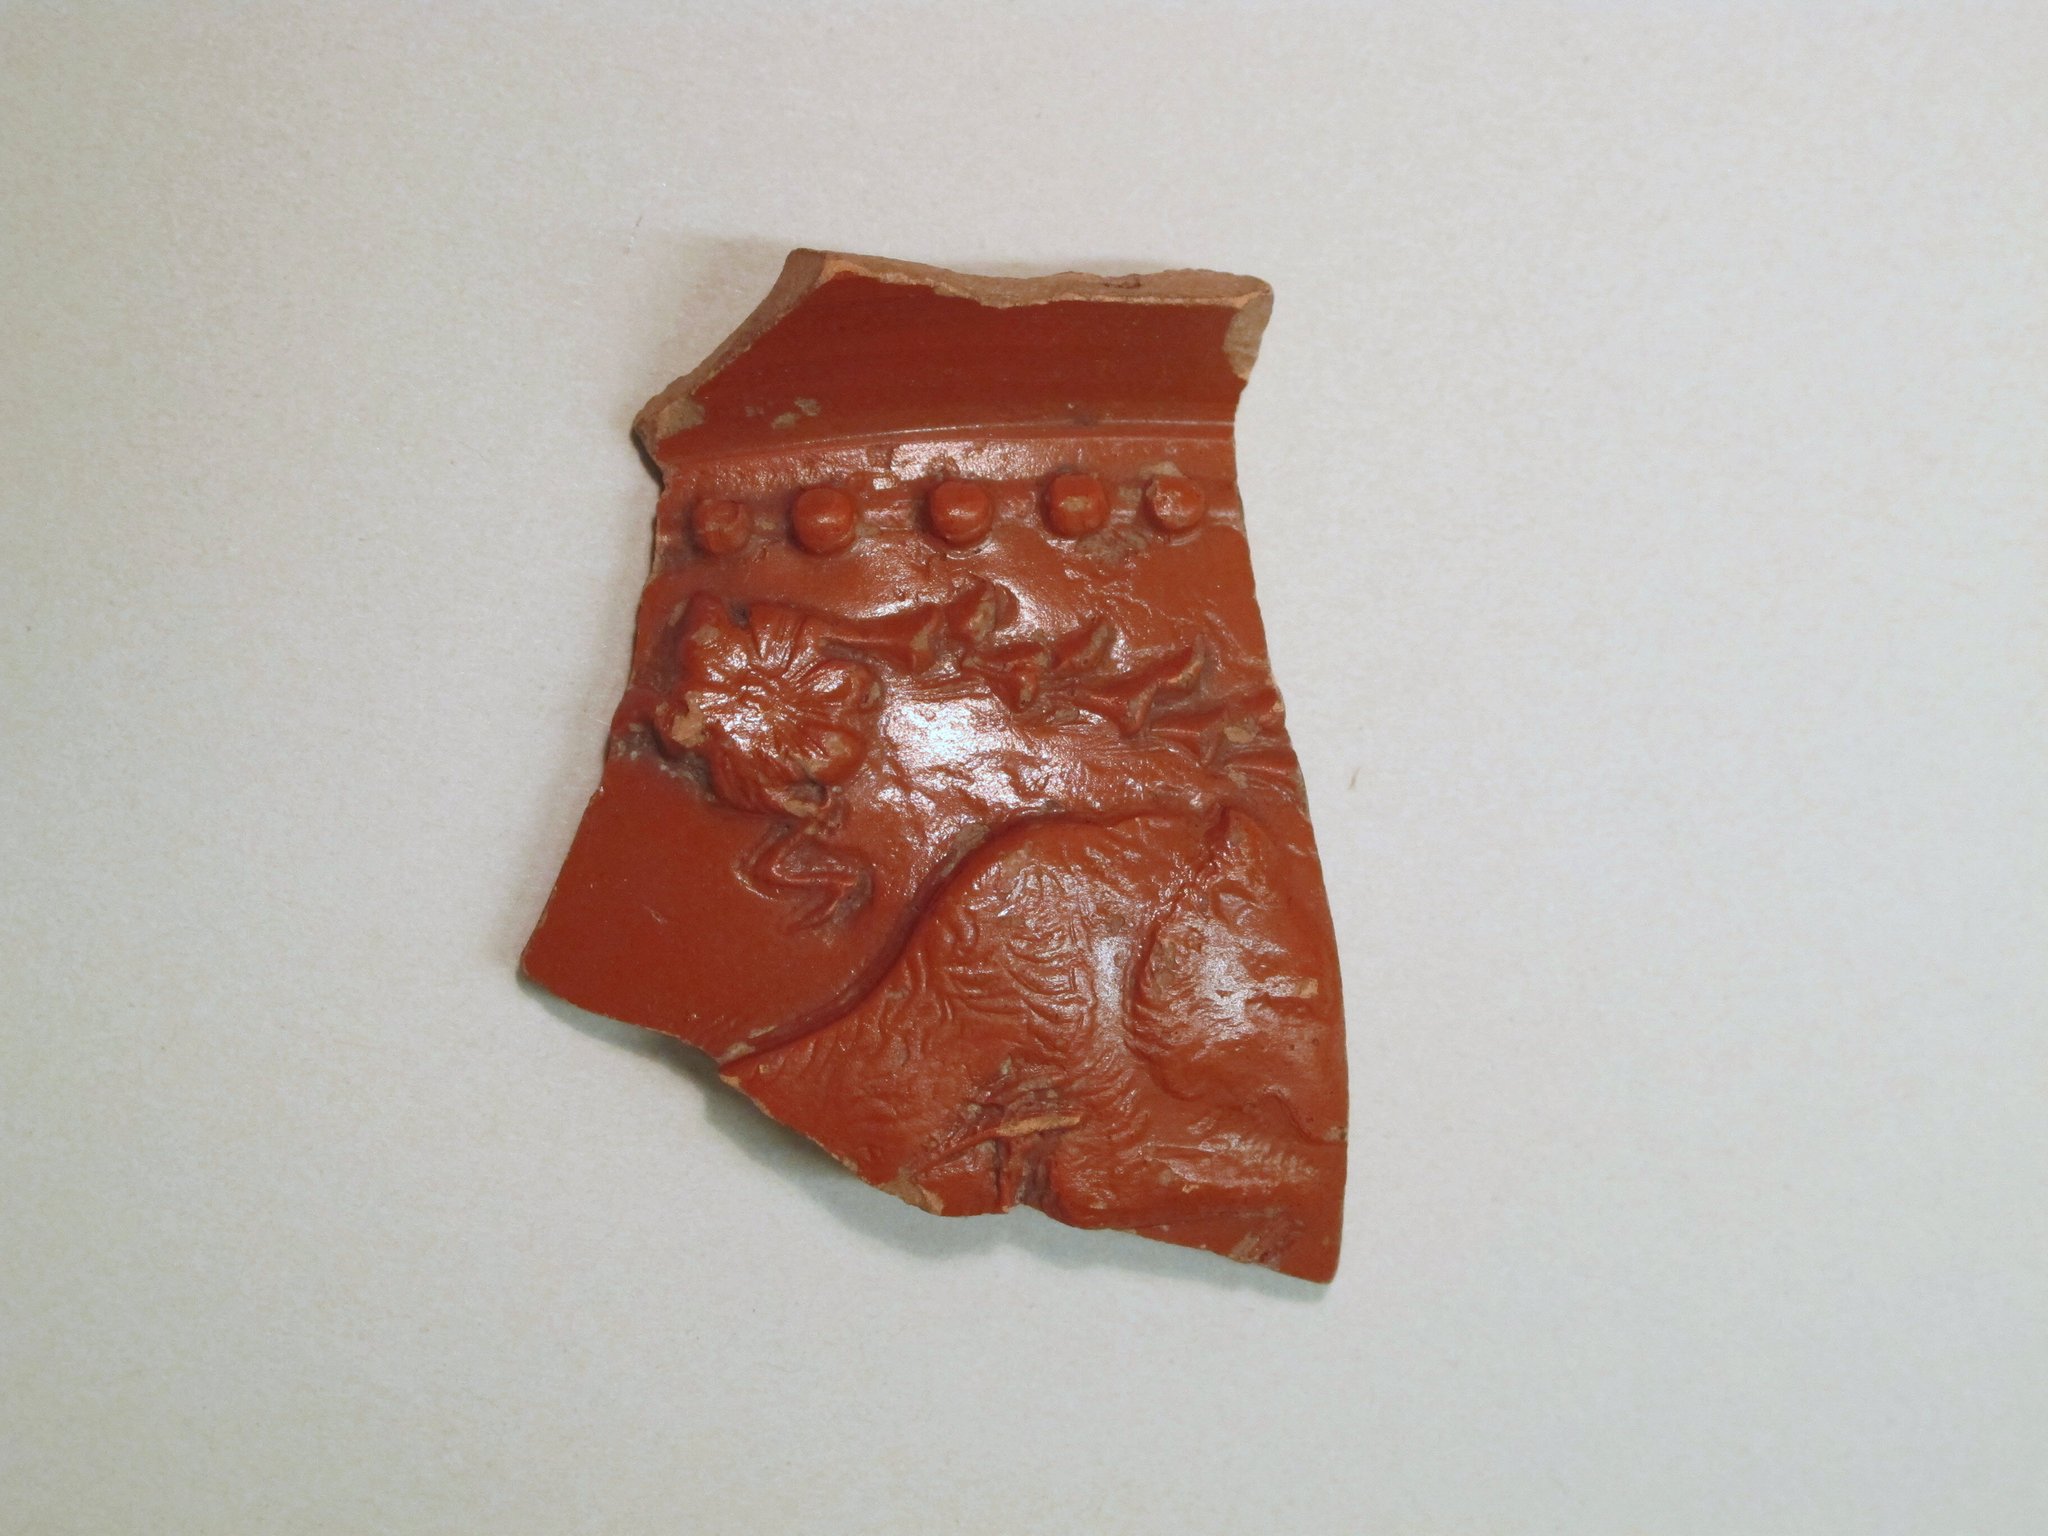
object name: vase fragment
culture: roman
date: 670 BCE-330 CE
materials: terracotta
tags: bears